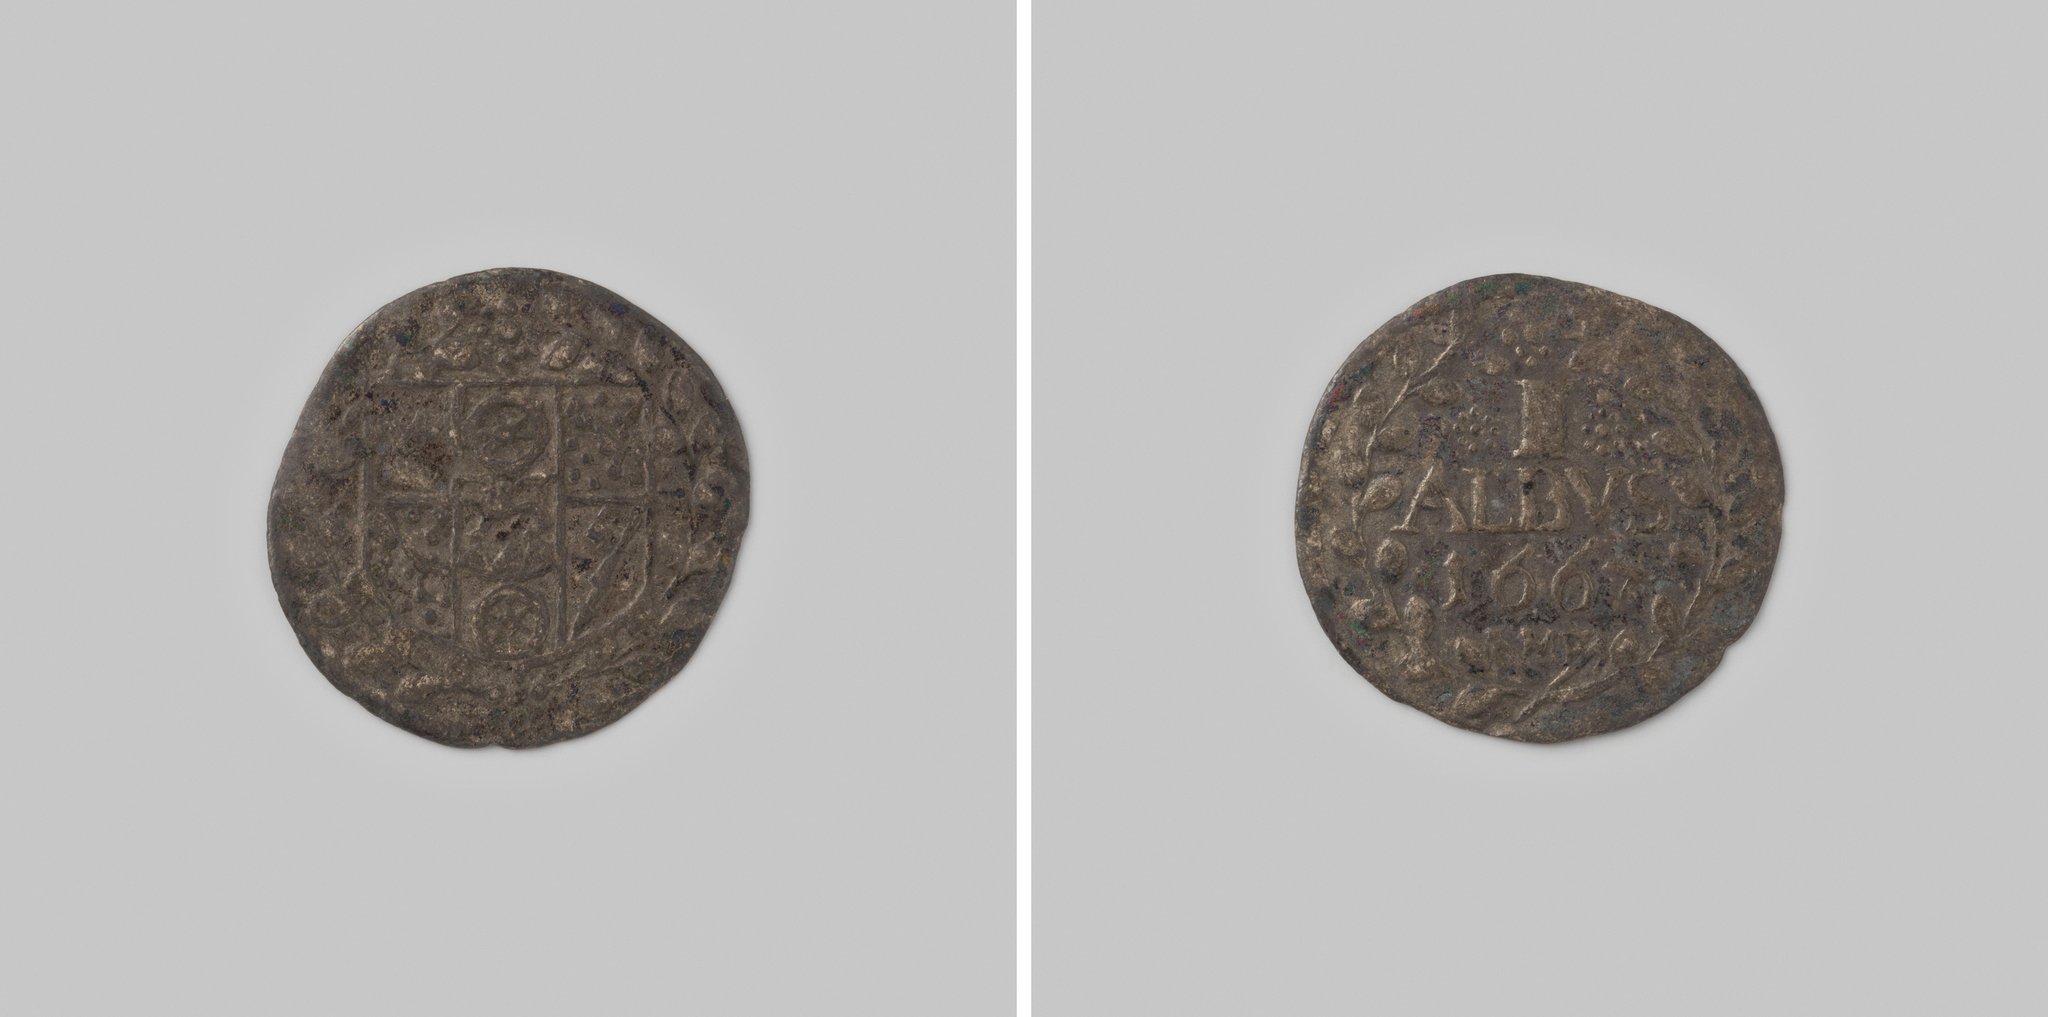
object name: coin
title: Bisdom Mainz, albus, Johann Philip von Schönborn, 1667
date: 1667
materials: silver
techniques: striking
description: Zilveren munt. Voorzijde: binnen twee takken samengesteld wapenschild, waarboven bloem. Keerzijde: binnen twee samengebonden takken waarde-aanduiding in twee regels, waaronder jaartal.